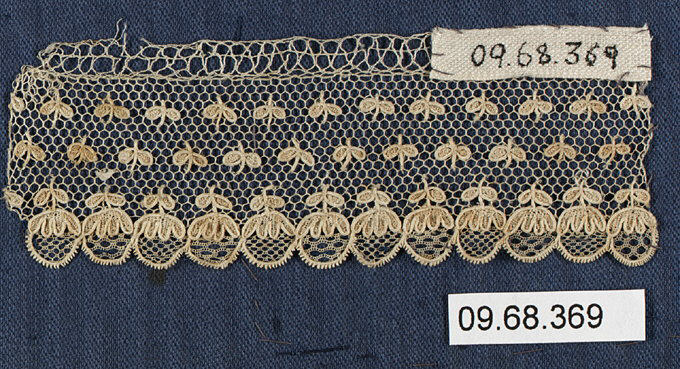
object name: fragment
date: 1801-1900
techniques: lace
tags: leaves